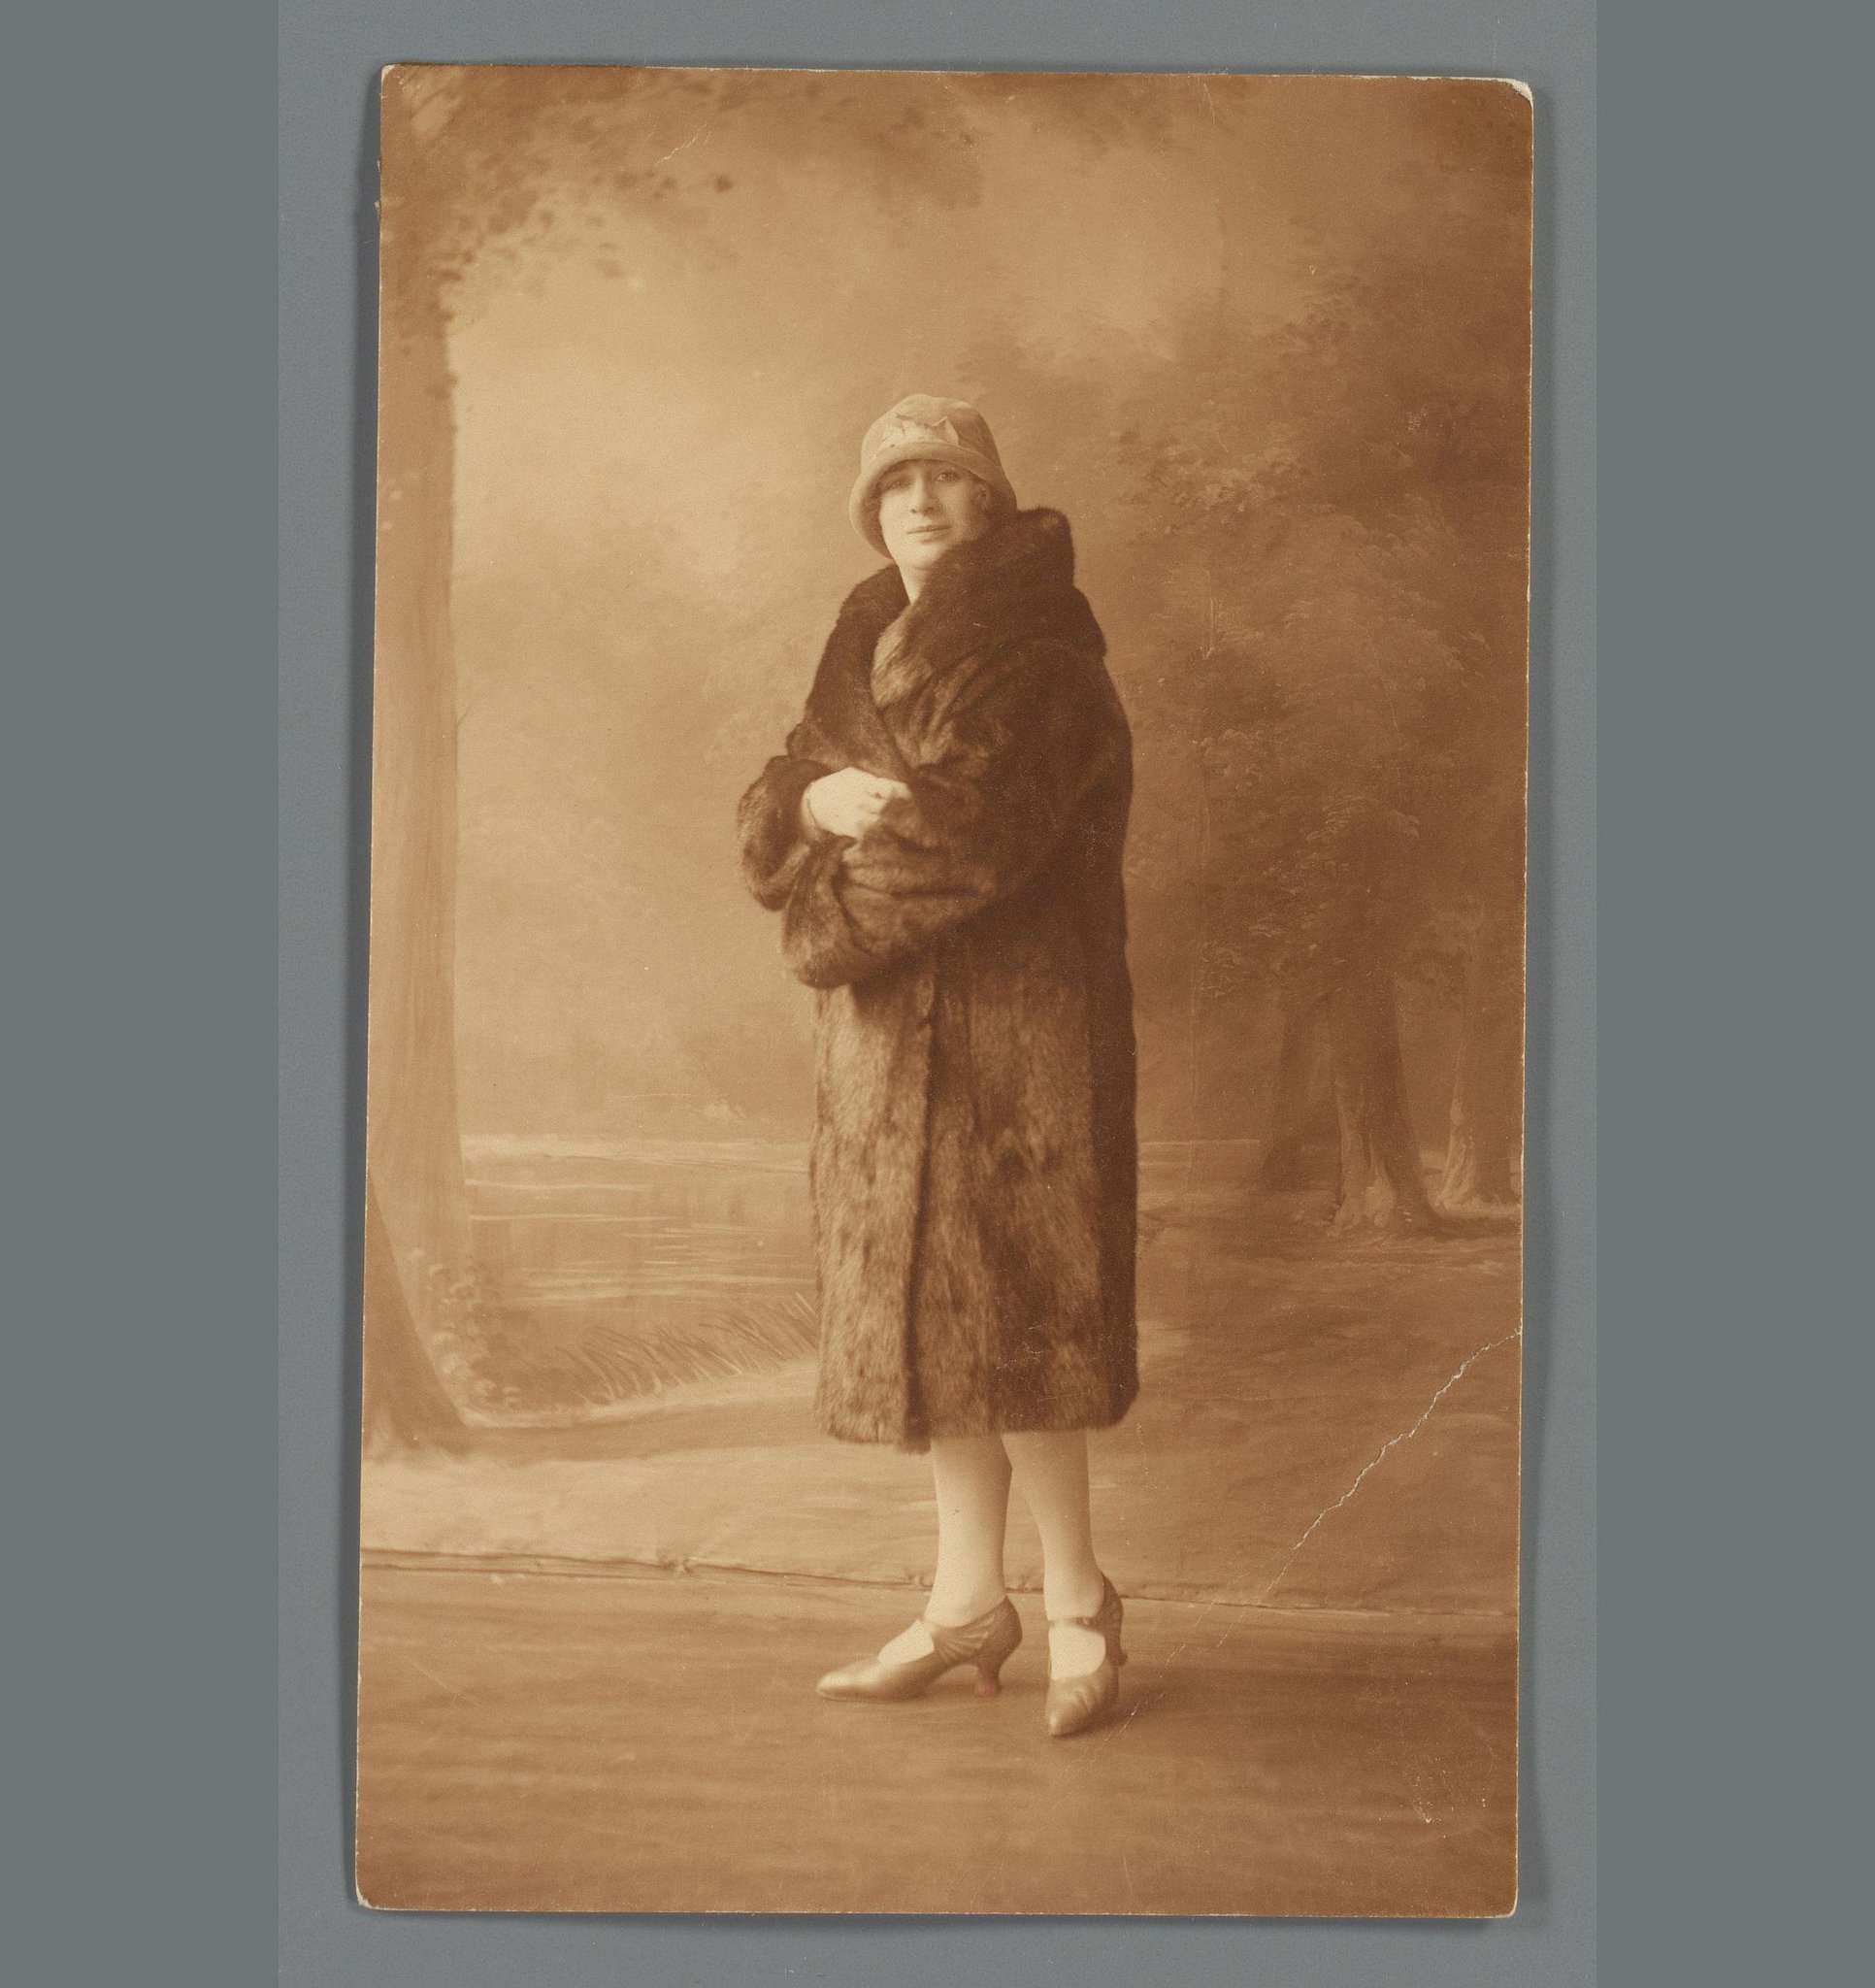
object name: ansichtkaart, prentbriefkaart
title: Portret van Cato Merks in een fotostudio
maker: wilhelm heinrich niestadt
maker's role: fotograaf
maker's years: 1876-1957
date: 1927-1933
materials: paper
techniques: gelatin silver print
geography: rotterdam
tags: historical persons - bb - woman, portrait of cabaret-artiste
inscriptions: inscription: ‘Cato Merks’, inscription: ‘Foto-Atelier/ Niestadt/ Rotterdam/ Oude Binnenweg 54/ Schiedam/ West, 58’